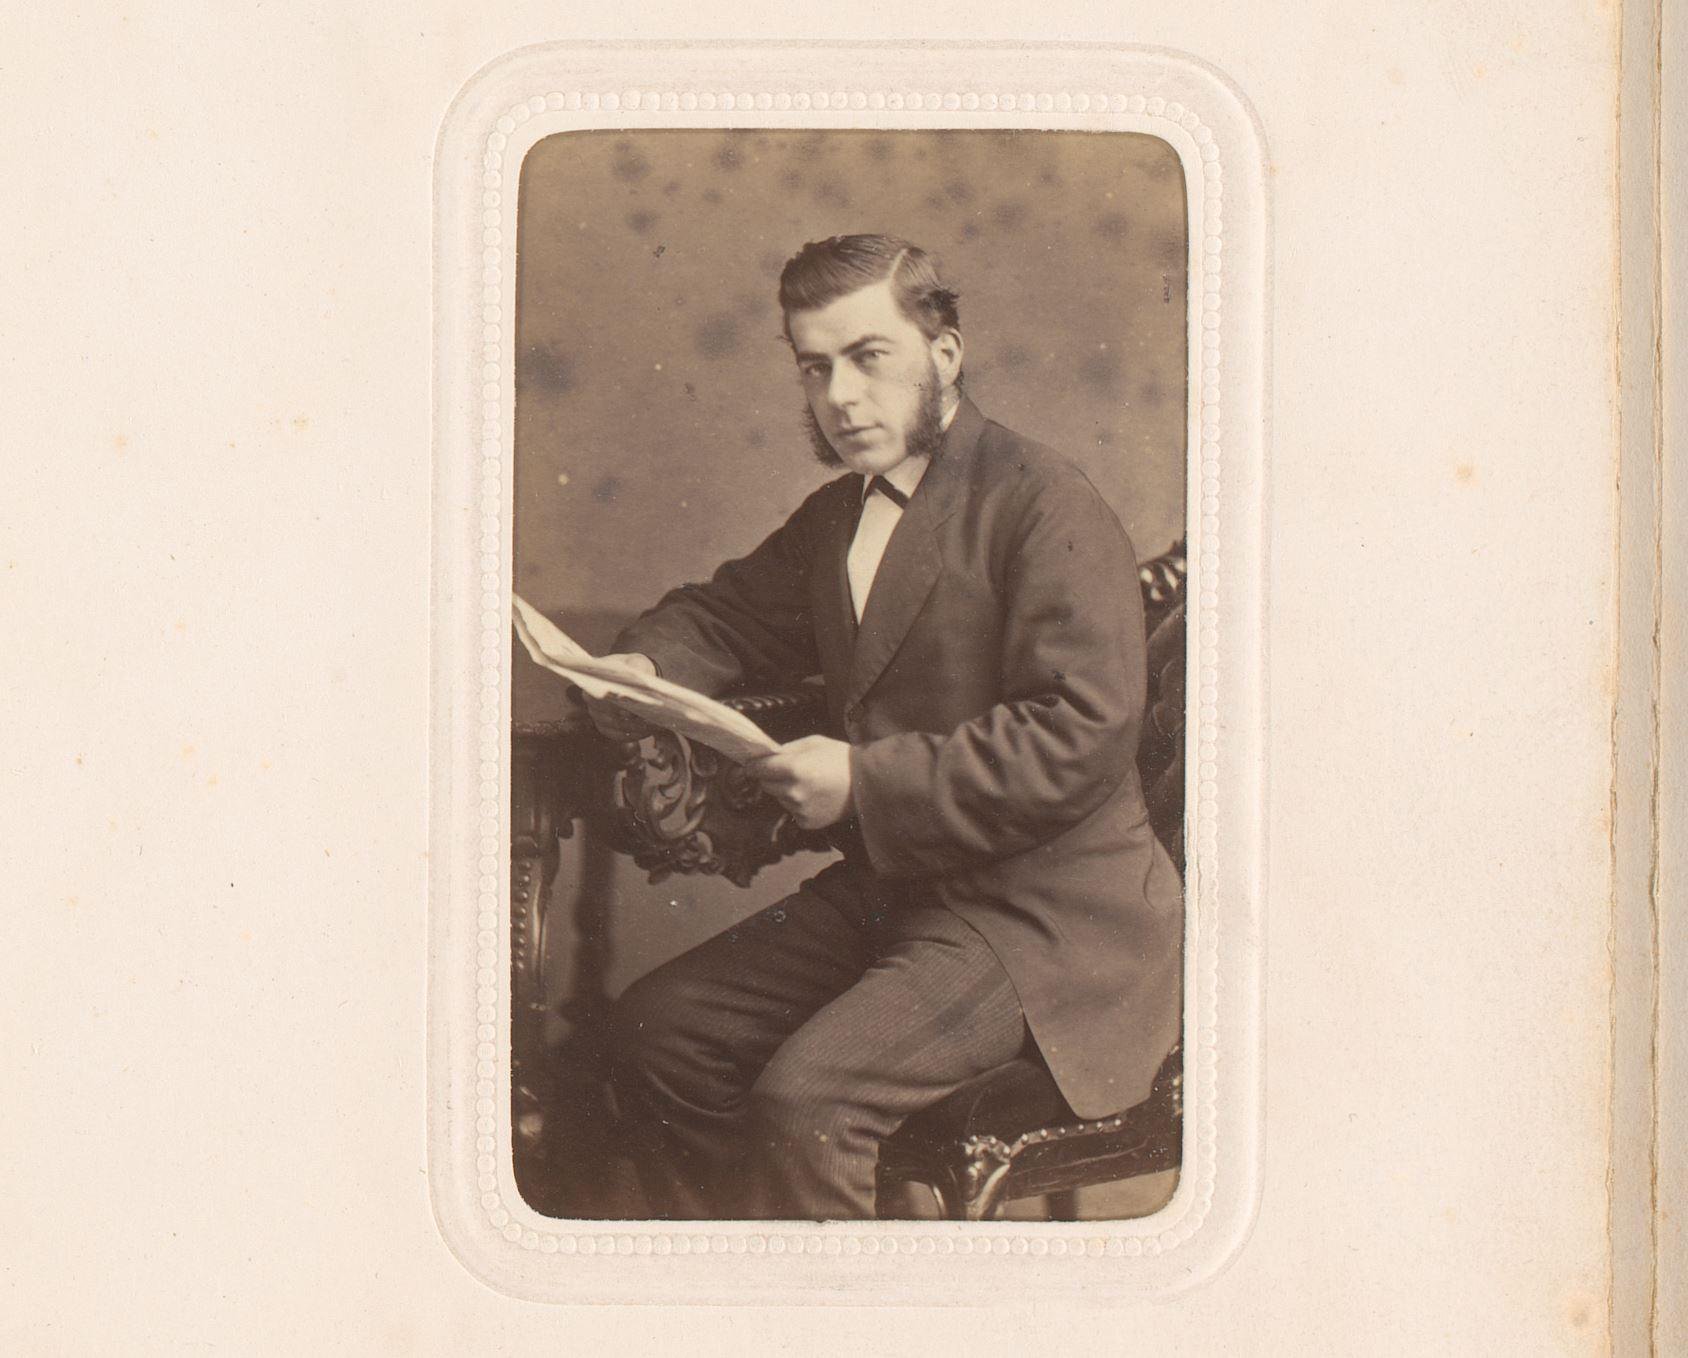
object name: carte de visite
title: Portret van een zittende man met papieren in de hand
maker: albert greiner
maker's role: fotograaf, fotostudio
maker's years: 1833-1890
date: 1861-1874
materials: cardboard, paper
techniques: albumen print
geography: amsterdam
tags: sitting figure, historical persons, paper (writing material)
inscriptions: inscription: ‘A. Greiner/ Photograf/ NIEUWENDIJK, L. 87/ AMSTERDAM’